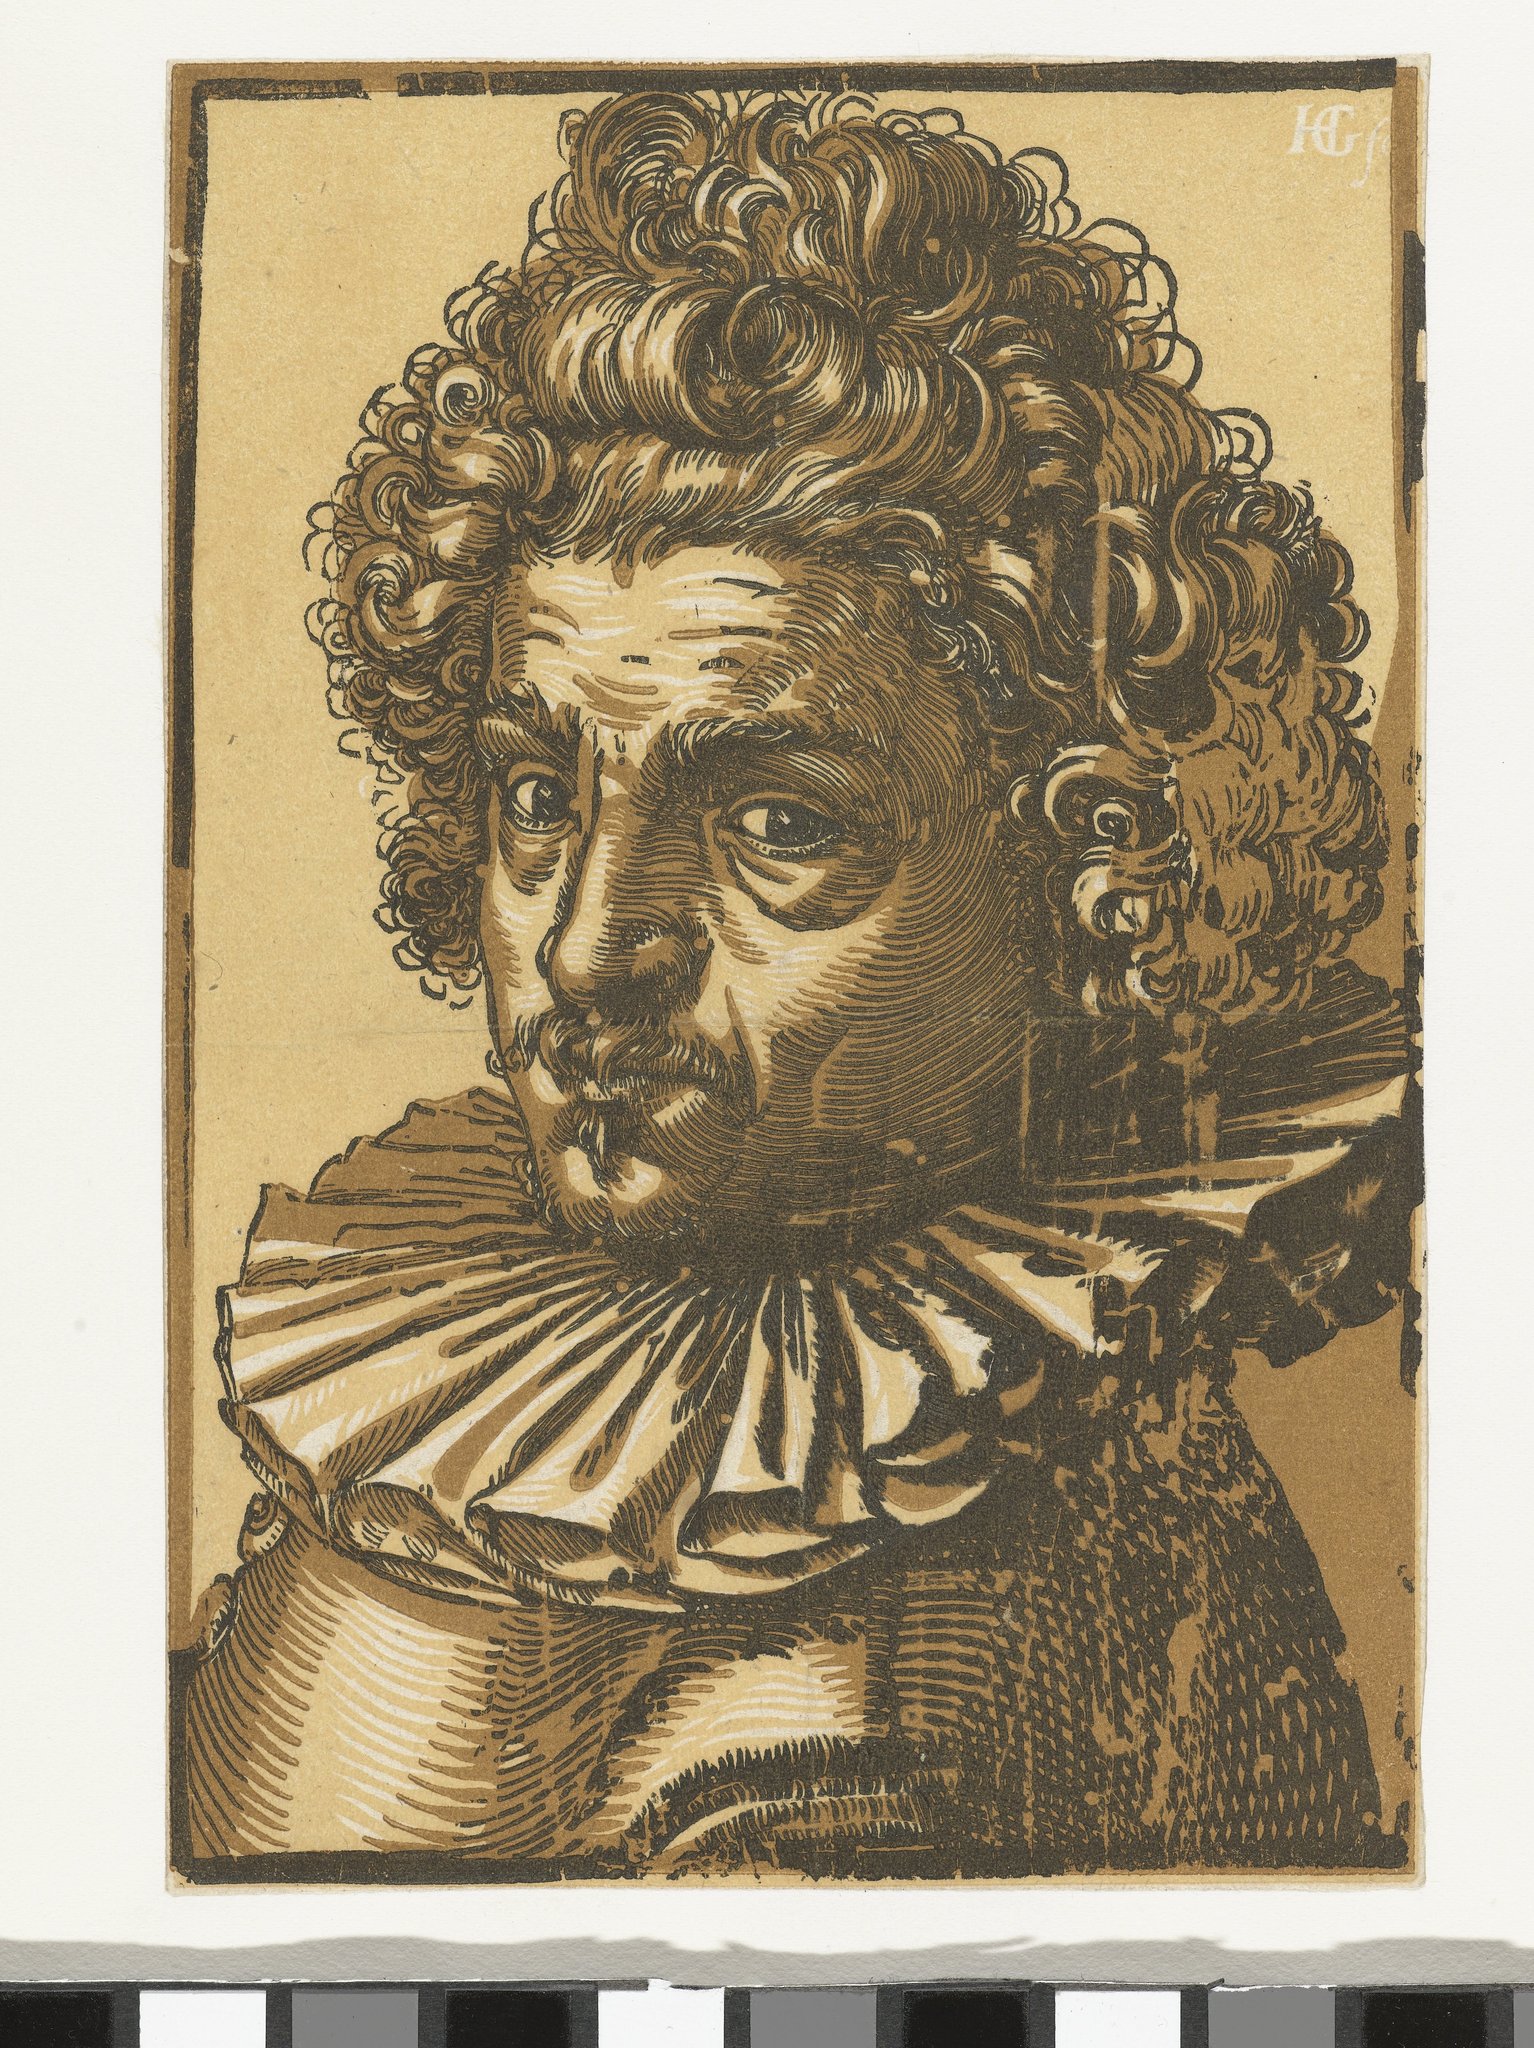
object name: print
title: Portret van Gillis van Breen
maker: hendrick goltzius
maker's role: draughtsman, painter, print maker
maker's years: 1558-1617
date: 1586-1590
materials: paper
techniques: woodcut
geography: haarlem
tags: print maker, gillis van breen, historical persons, portrait, self-portrait of artist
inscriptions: collector's mark: Lugt 240, collector's mark: Lugt 2228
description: Portret van een man (Gillis van Breen, een vriend, misschien ook assistent van Goltzius) met krullend haar en een geplooide kraag, op de linkerzijde gezien, de blik gericht op de beschouwer.